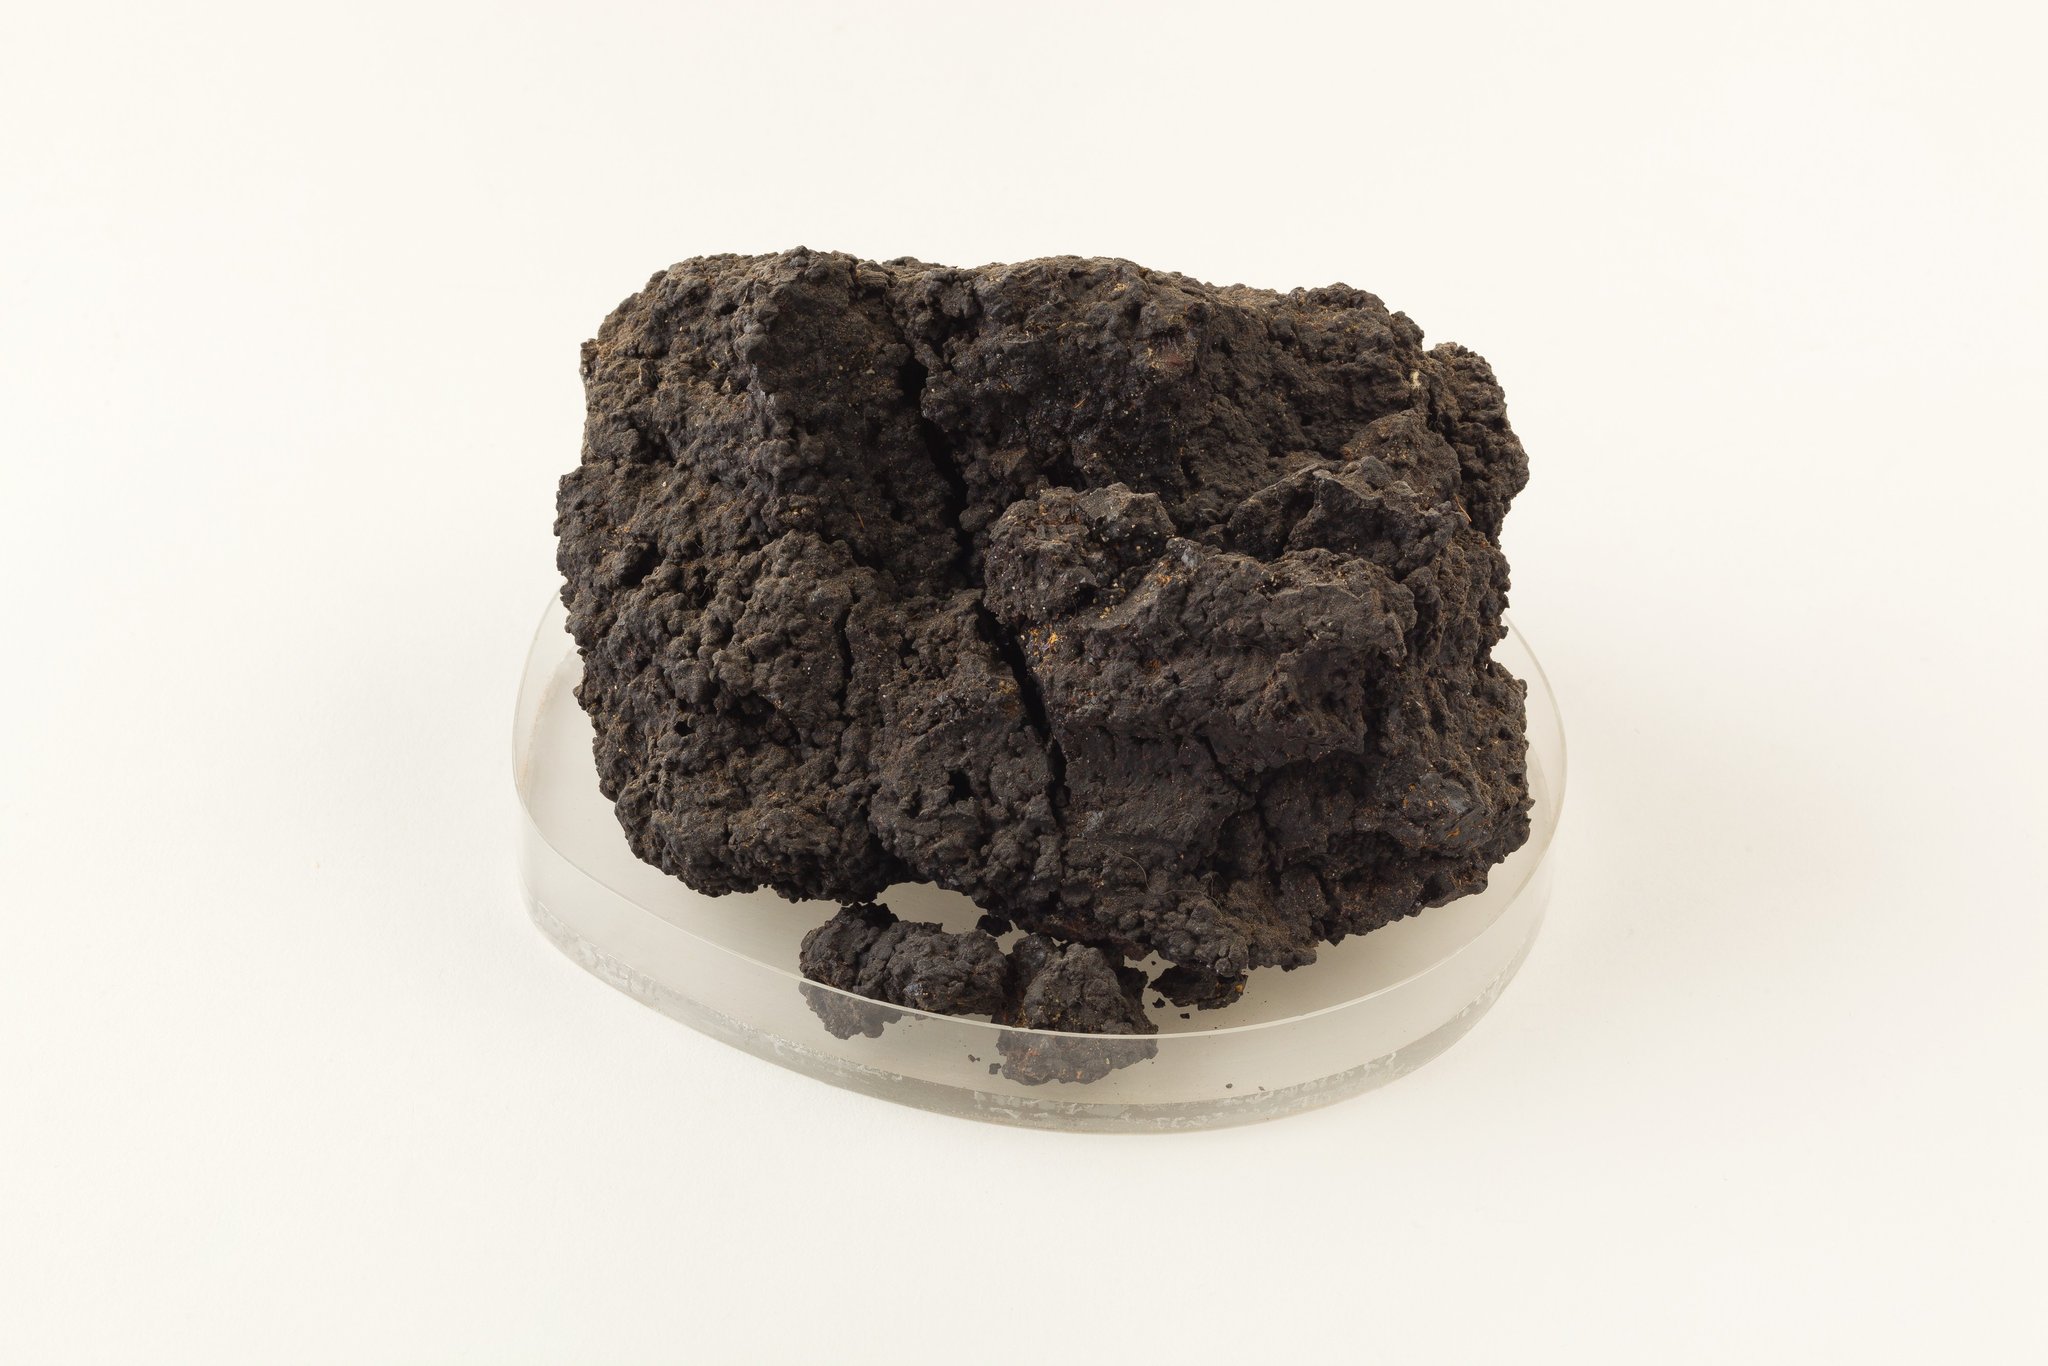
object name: food, fruit cake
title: Fruit Cake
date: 1492-1473 BCE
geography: egypt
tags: food